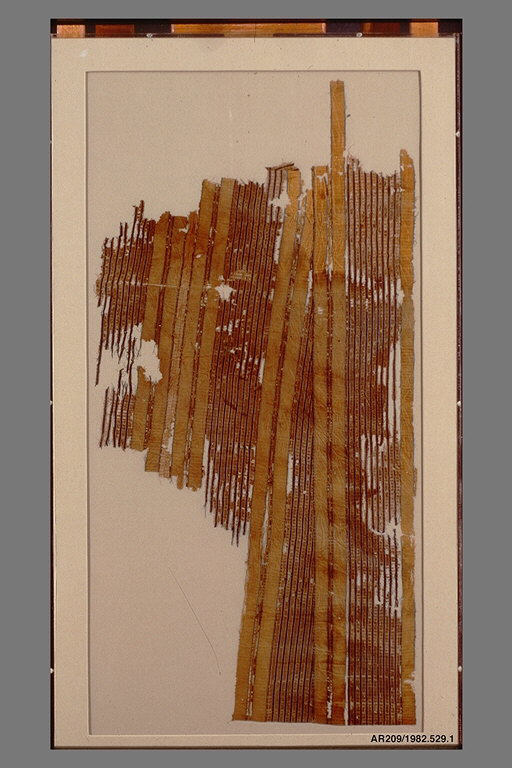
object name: textile fragment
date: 1301-1500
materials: cotton, silk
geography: egypt